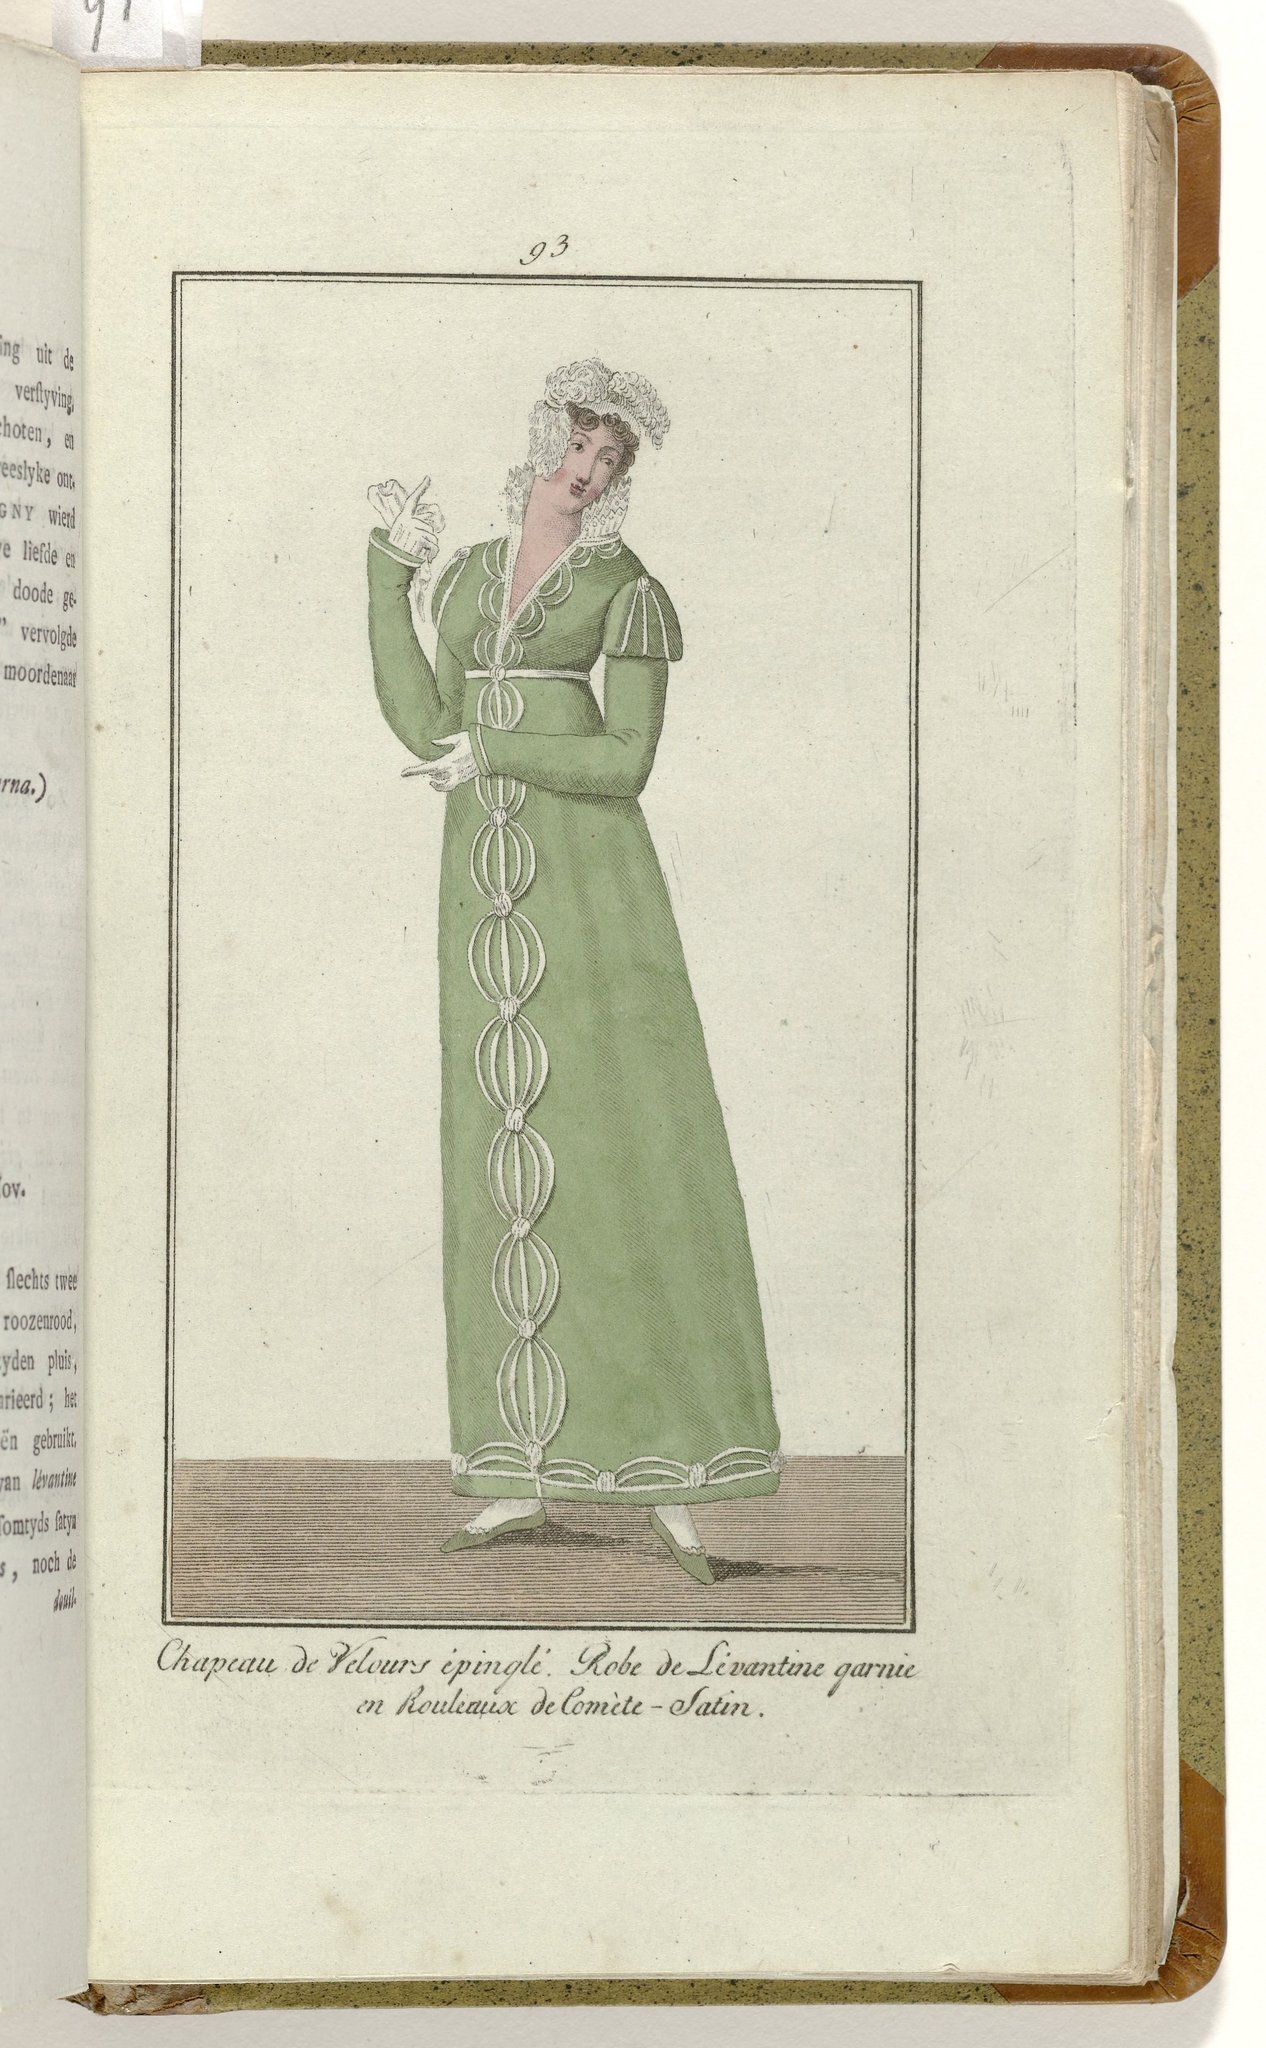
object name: magazine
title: Elegantia, of tijdschrift van mode, luxe en smaak voor dames, November 1809, No. 93: Chapeau de Velours épinglé...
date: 1809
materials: paper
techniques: engraving, hand coloring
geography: amsterdam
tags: handkerchief (+ women's clothes), border, ribbon, braid (+ women's clothes), fashion plates, head-gear: hat (+ women's clothes), dress, gown (+ women's clothes)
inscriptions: caption: ‘Chapeau de Velours épinglé. Robe de Lévantine garnie en Rouleaux de Comète-Satin.’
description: Volgens de begeleidende tekst (p. 352): Japon van 'levantine' gegarneerd met een rouleaux van 'comète-satin'(satijn). Hoed van 'velours épinglé' met gefriseerde pluimen. Prent uit het modetijdschrift Elegantia, of tijdschrift van mode, luxe en smaak voor dames 1807-1814 (onderbroken door de periode 1811-1813).